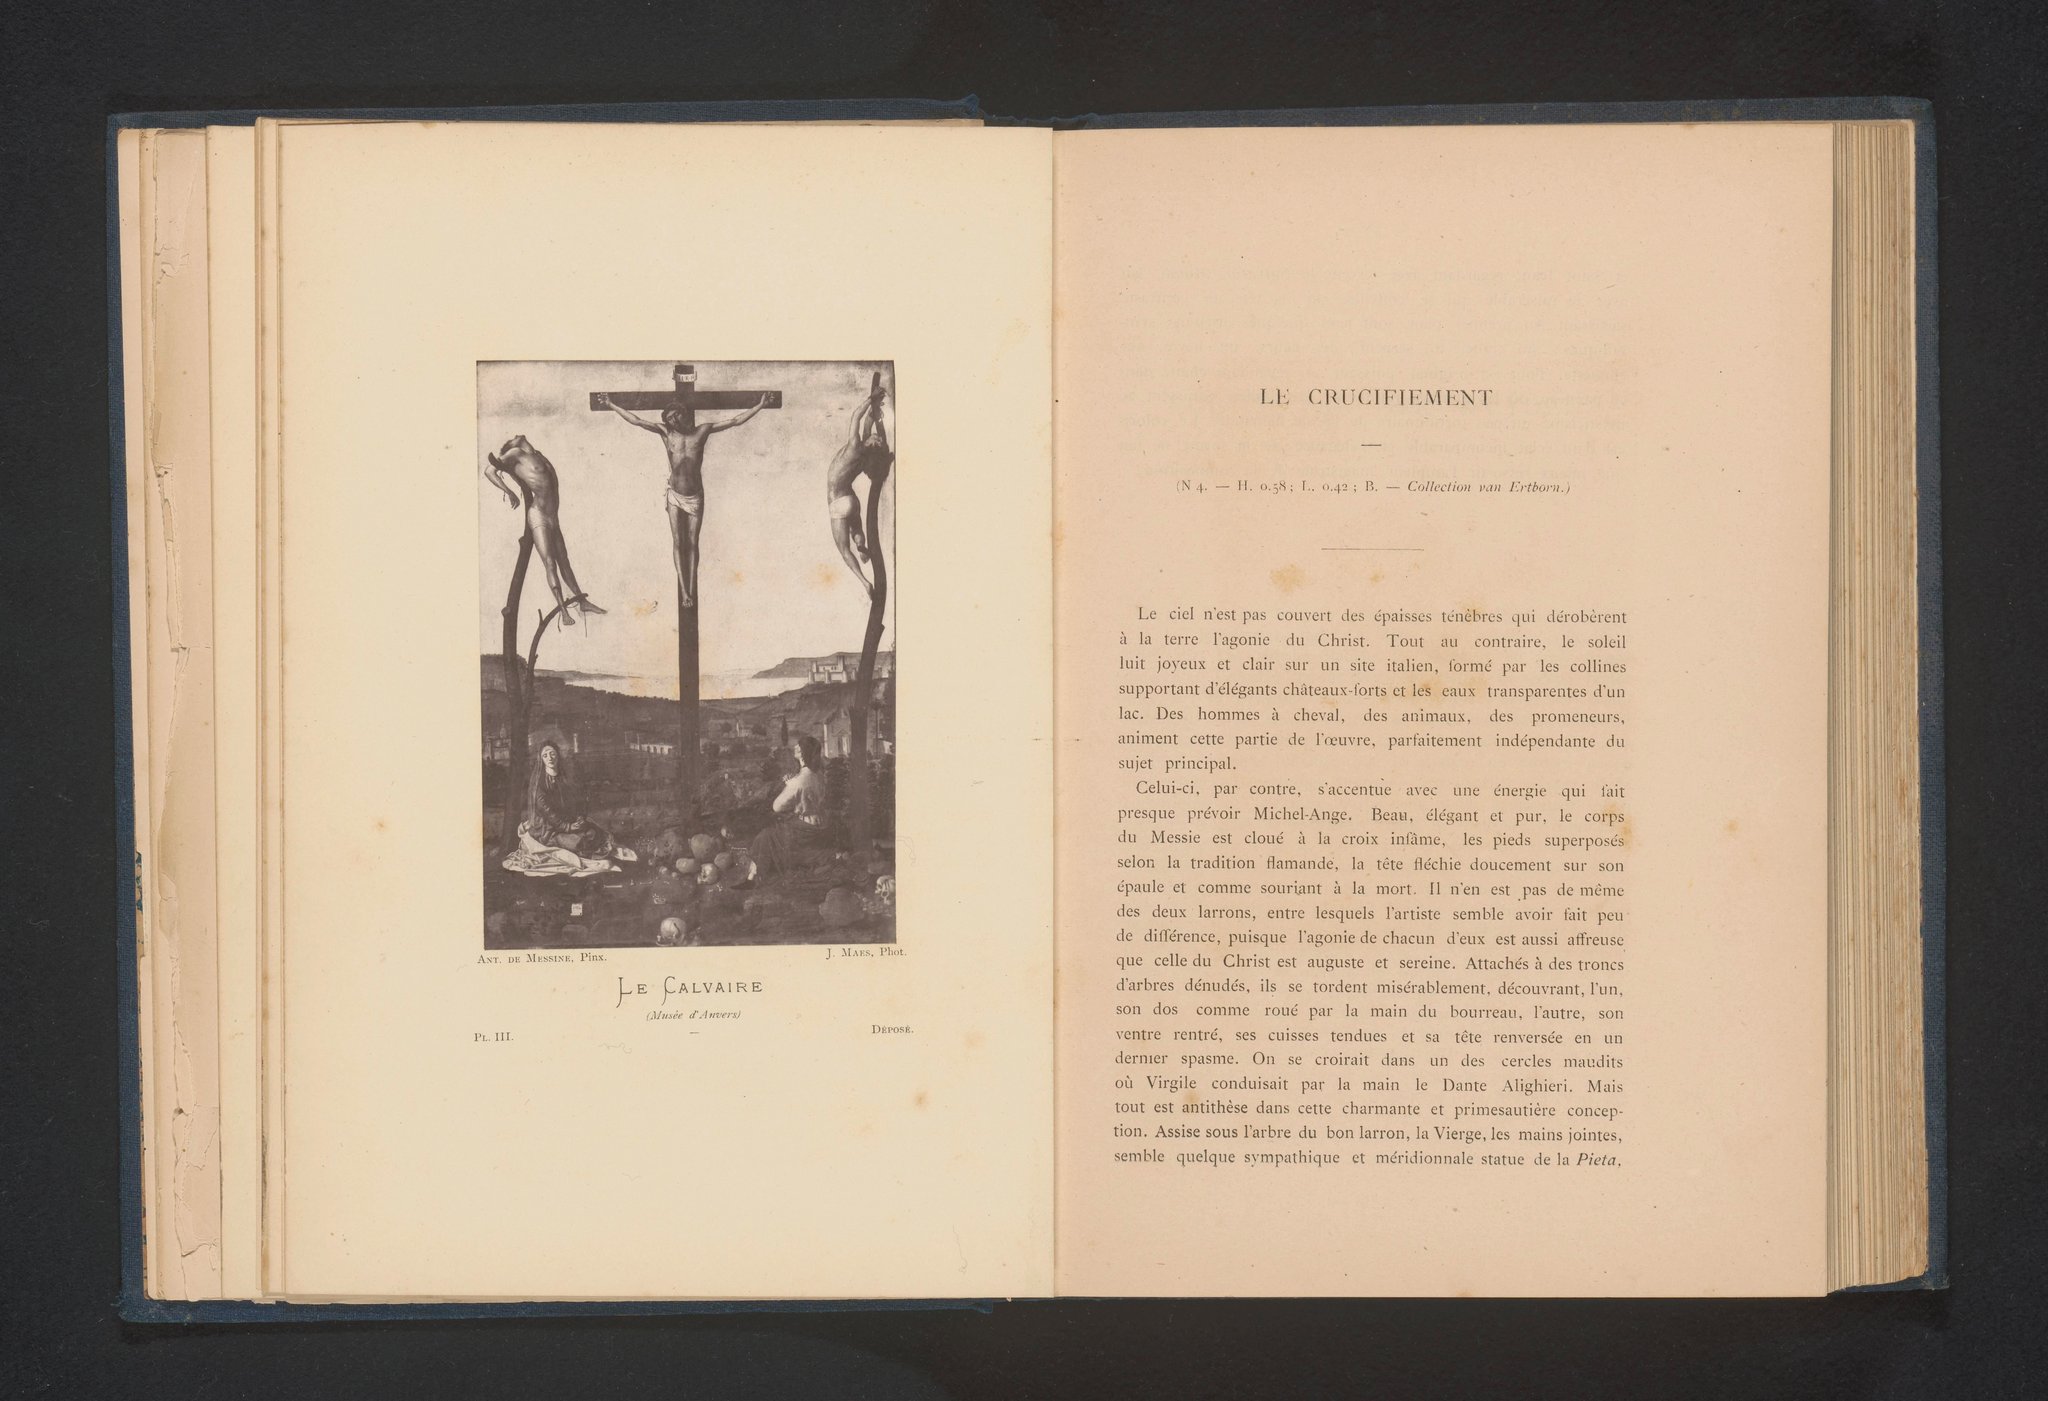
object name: page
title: Le Calvaire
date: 1872-1877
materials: paper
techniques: woodburytype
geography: antwerp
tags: crucified christ, with particular persons under the cross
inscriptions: inscription: ‘(Musée d'Anvers)/ Pl. III. Déposé.’